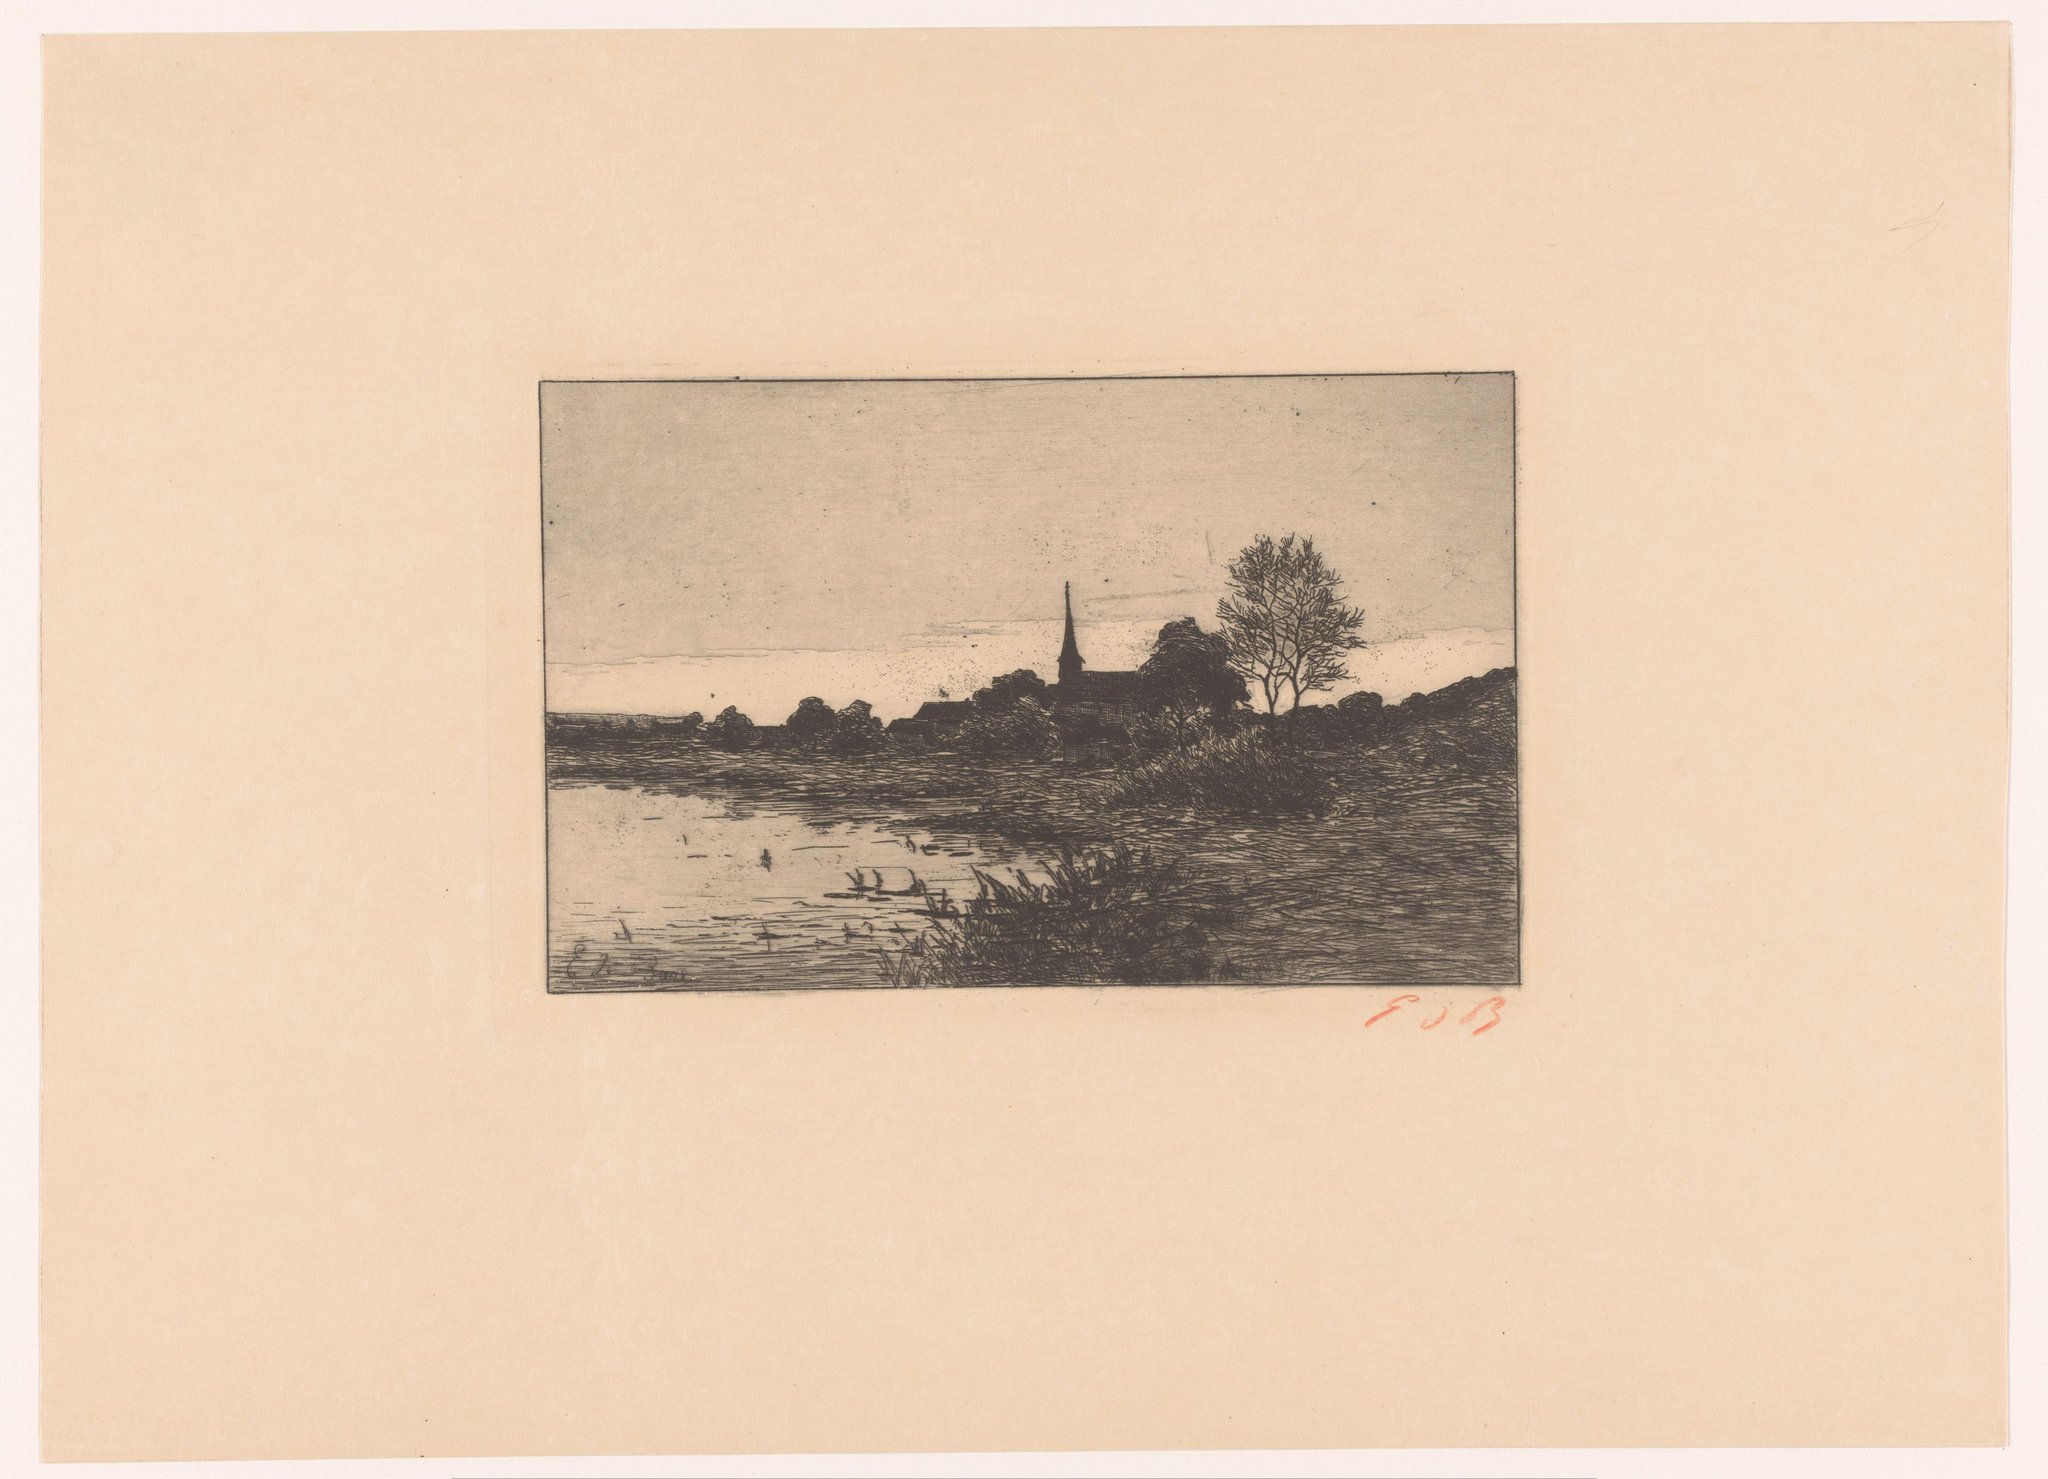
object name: print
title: Gezicht op een meer bij het vallen van de avond, op de achtergrond een kerktoren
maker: emile de baré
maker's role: painter, print maker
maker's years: 1855-1902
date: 1865-1902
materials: paper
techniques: drypoint, etching, intaglio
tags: lake, parts of church exterior and annexes: tower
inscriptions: collector's mark: Lugt 2228